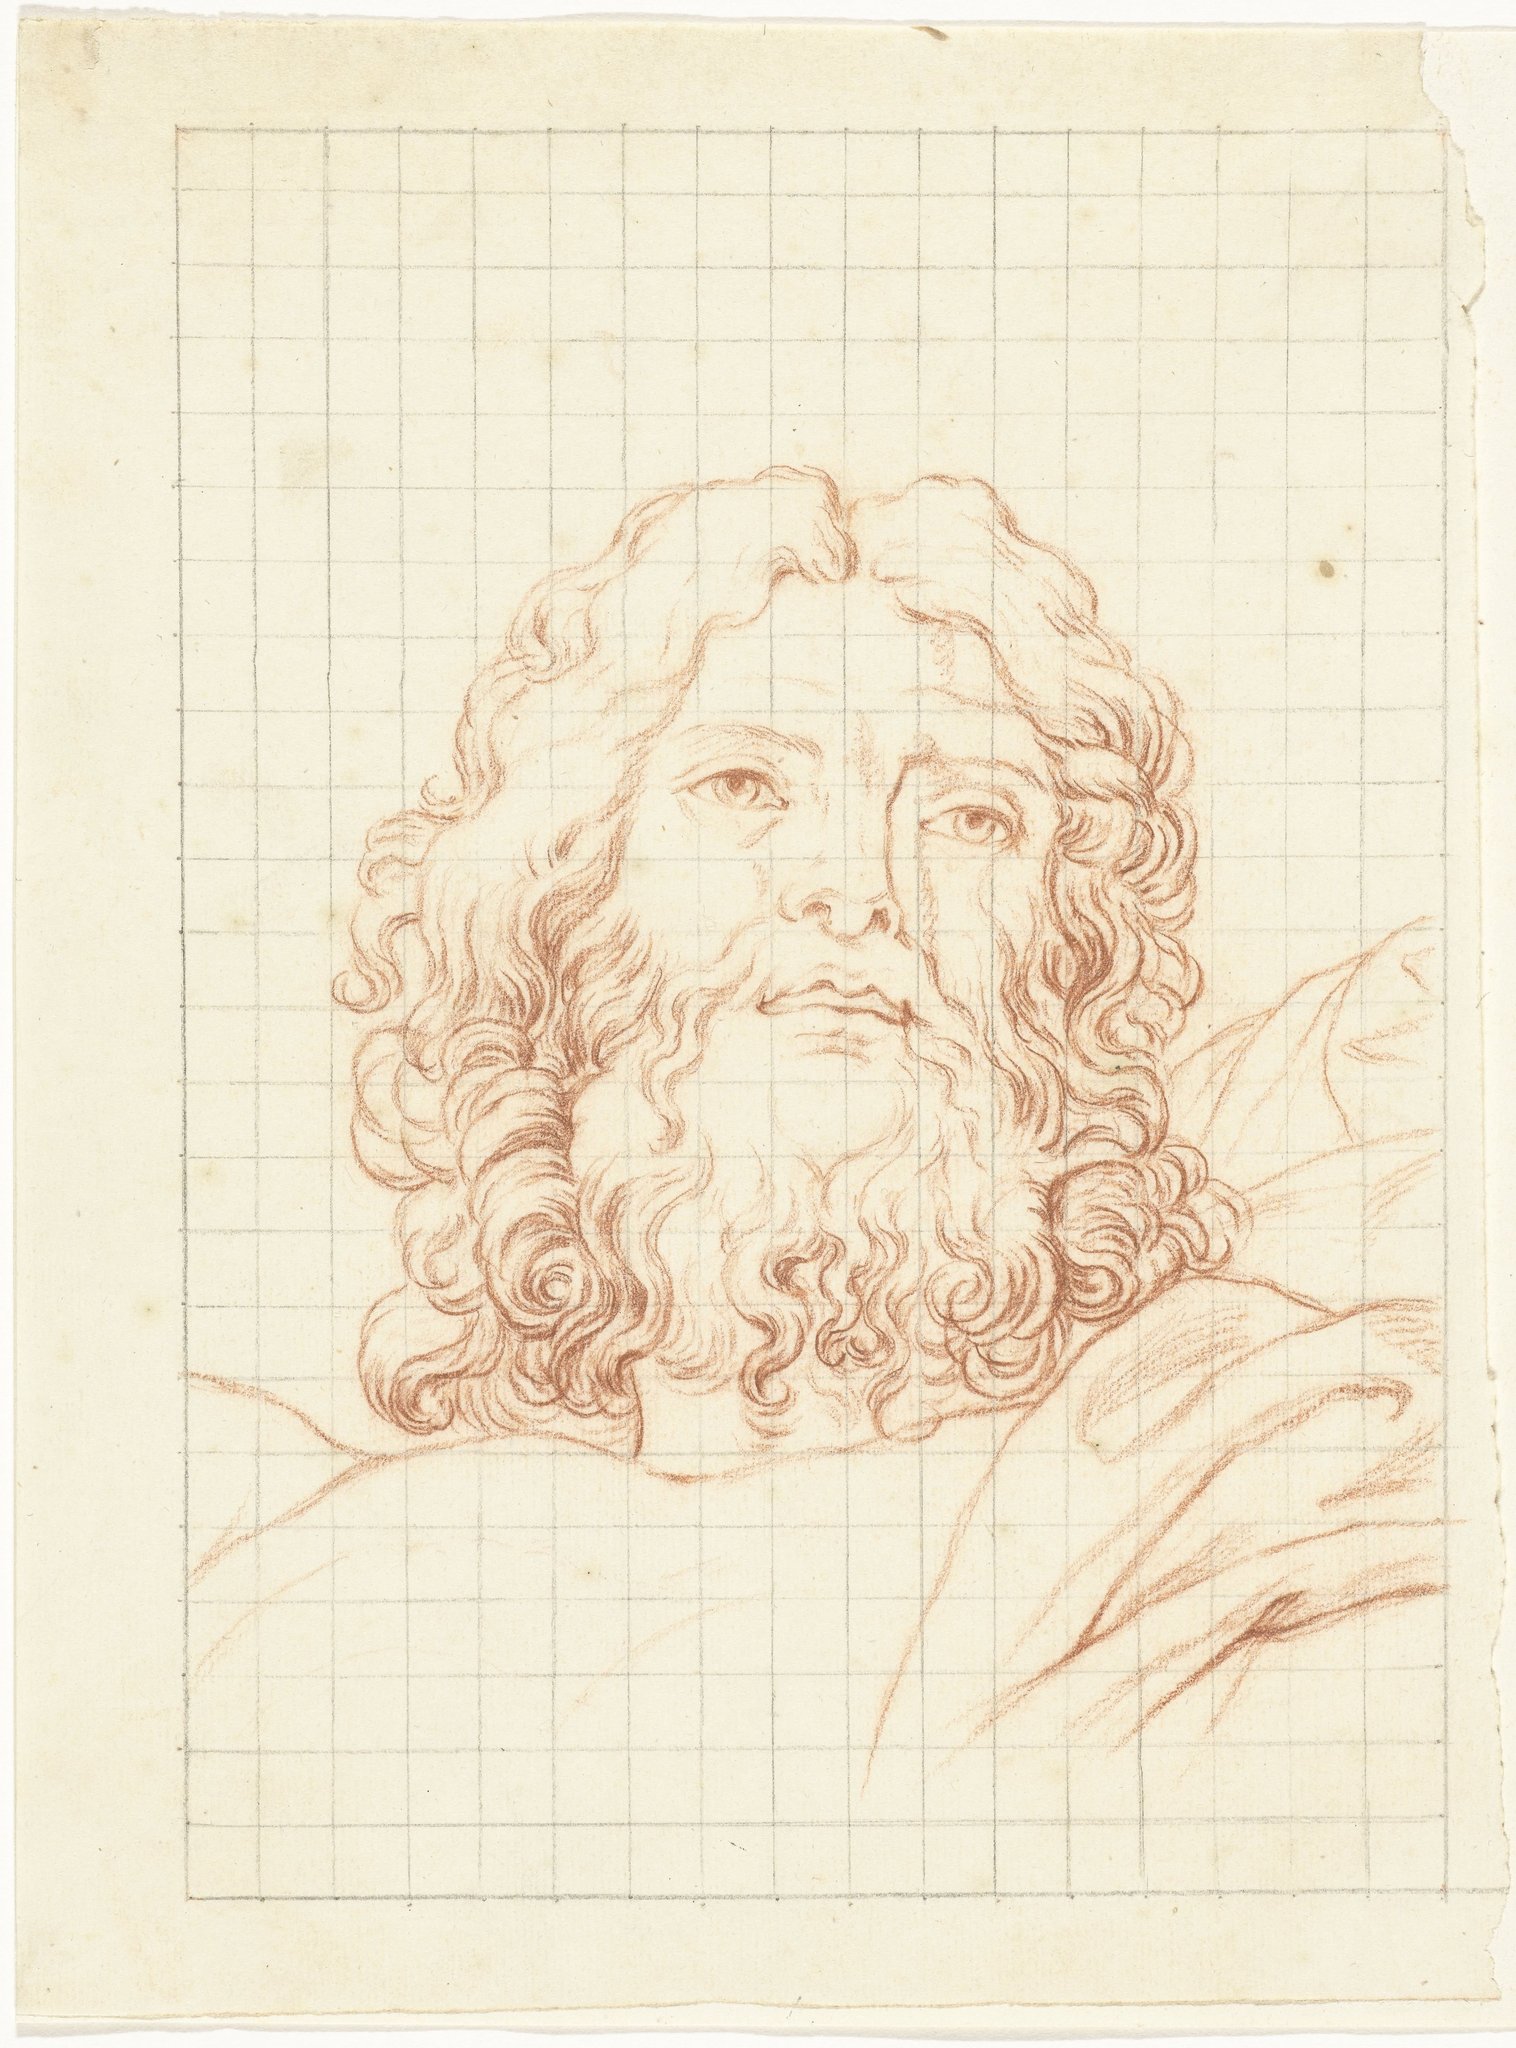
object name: drawing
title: Hoofd van verrijzende Christus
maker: bernard picart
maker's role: draughtsman, print maker, publisher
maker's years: 1673-1733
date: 1683-1733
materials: chalk, paper, pencil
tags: christ, usually holding a banner, arises from the grave; often combined with sleeping and/or frightened soldiers